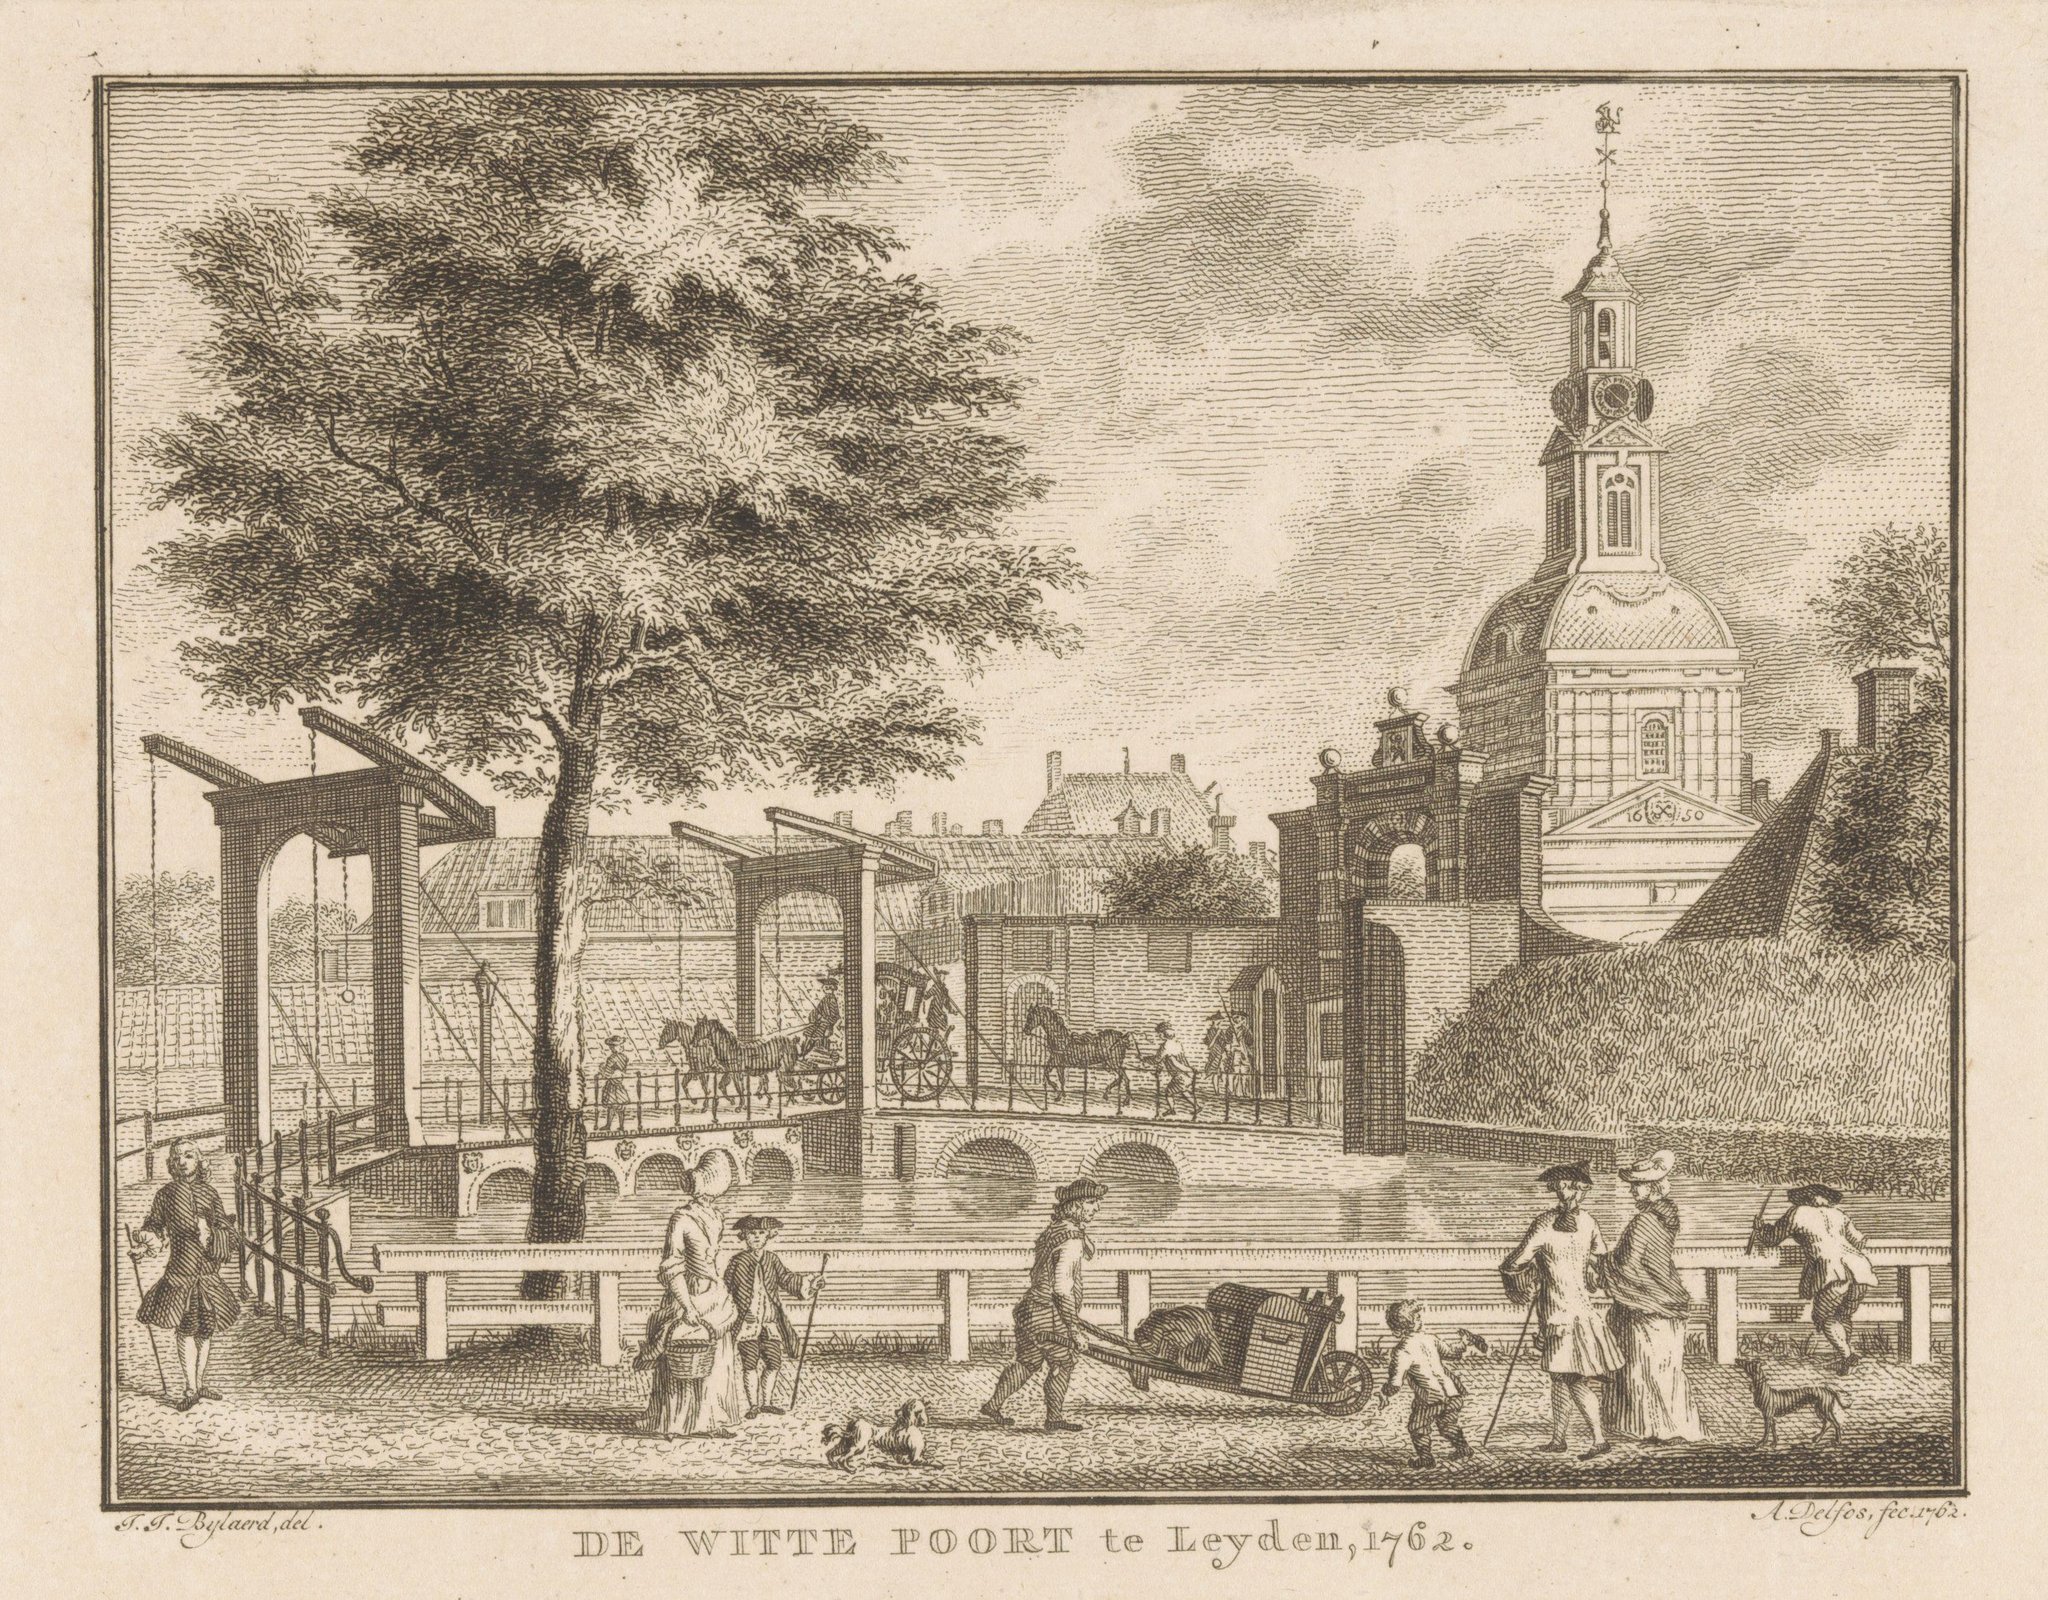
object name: book illustration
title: De Witte Poort te Leyden, 1762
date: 1762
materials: paper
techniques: engraving, etching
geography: leiden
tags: bridge, city-gate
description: Prent ook gebruikt in: Mieris, Frans van (II). Beschryving der stad Leyden, haare gelegenheid, oorsprong, vergrootinge, oude en hedendaagsche gedaante (…). 3 delen. Leiden: weduwe Abraham Honkoop, Cornelis van Hoogeveen junior e.a., 1762-1784, dl. 1 (1762), tussen p. 14 en 15.